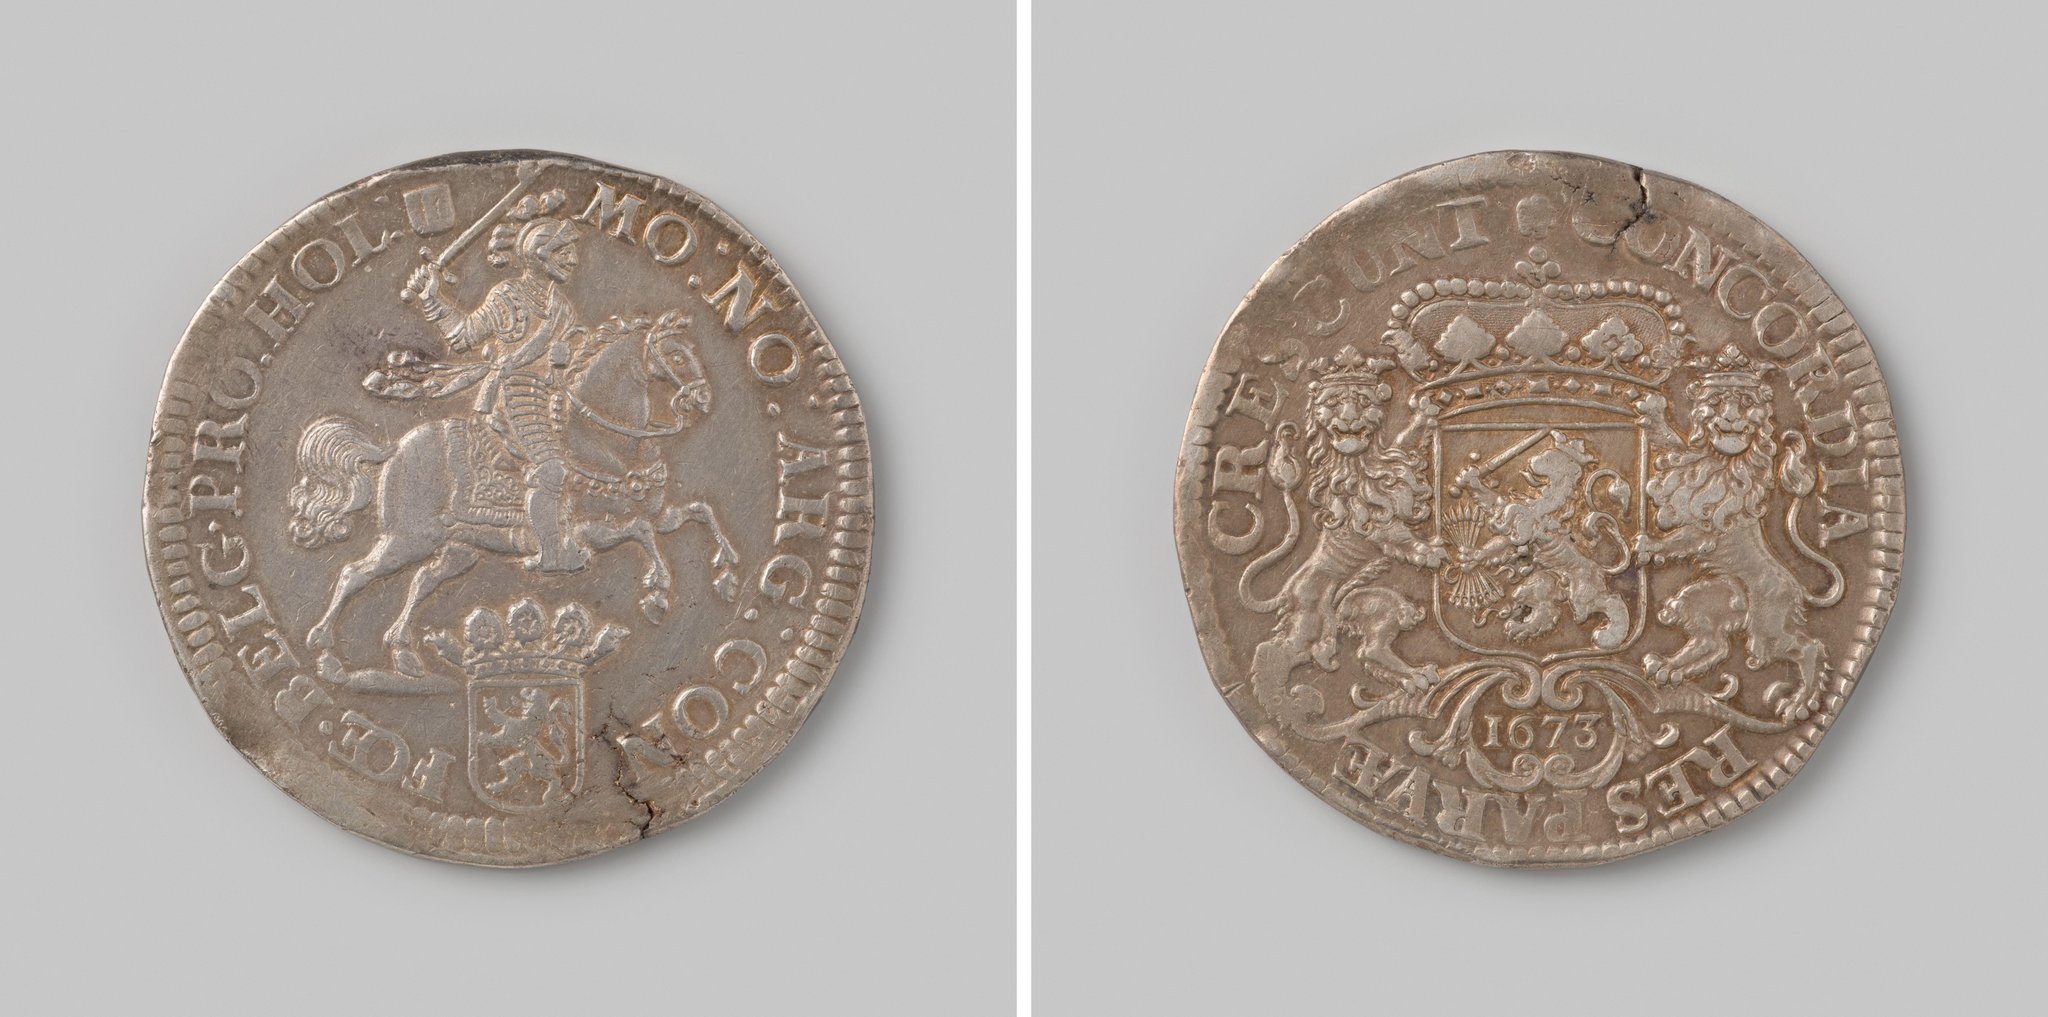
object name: silver rider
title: Holland, zilveren rijder, 1673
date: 1673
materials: silver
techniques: striking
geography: dordrecht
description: Zilveren munt. Voorzijde: ruiter met zwaard naar rechts. Daaronder gekroond Hollands wapenschild. Keerzijde: door twee leeuwen gehouden gekroond generaliteitswapenschild. Daaronder cartouche, waarin jaartal. Aan het eind van het omschrift bovenaan wapenschildje van de muntplaats: Dordrecht